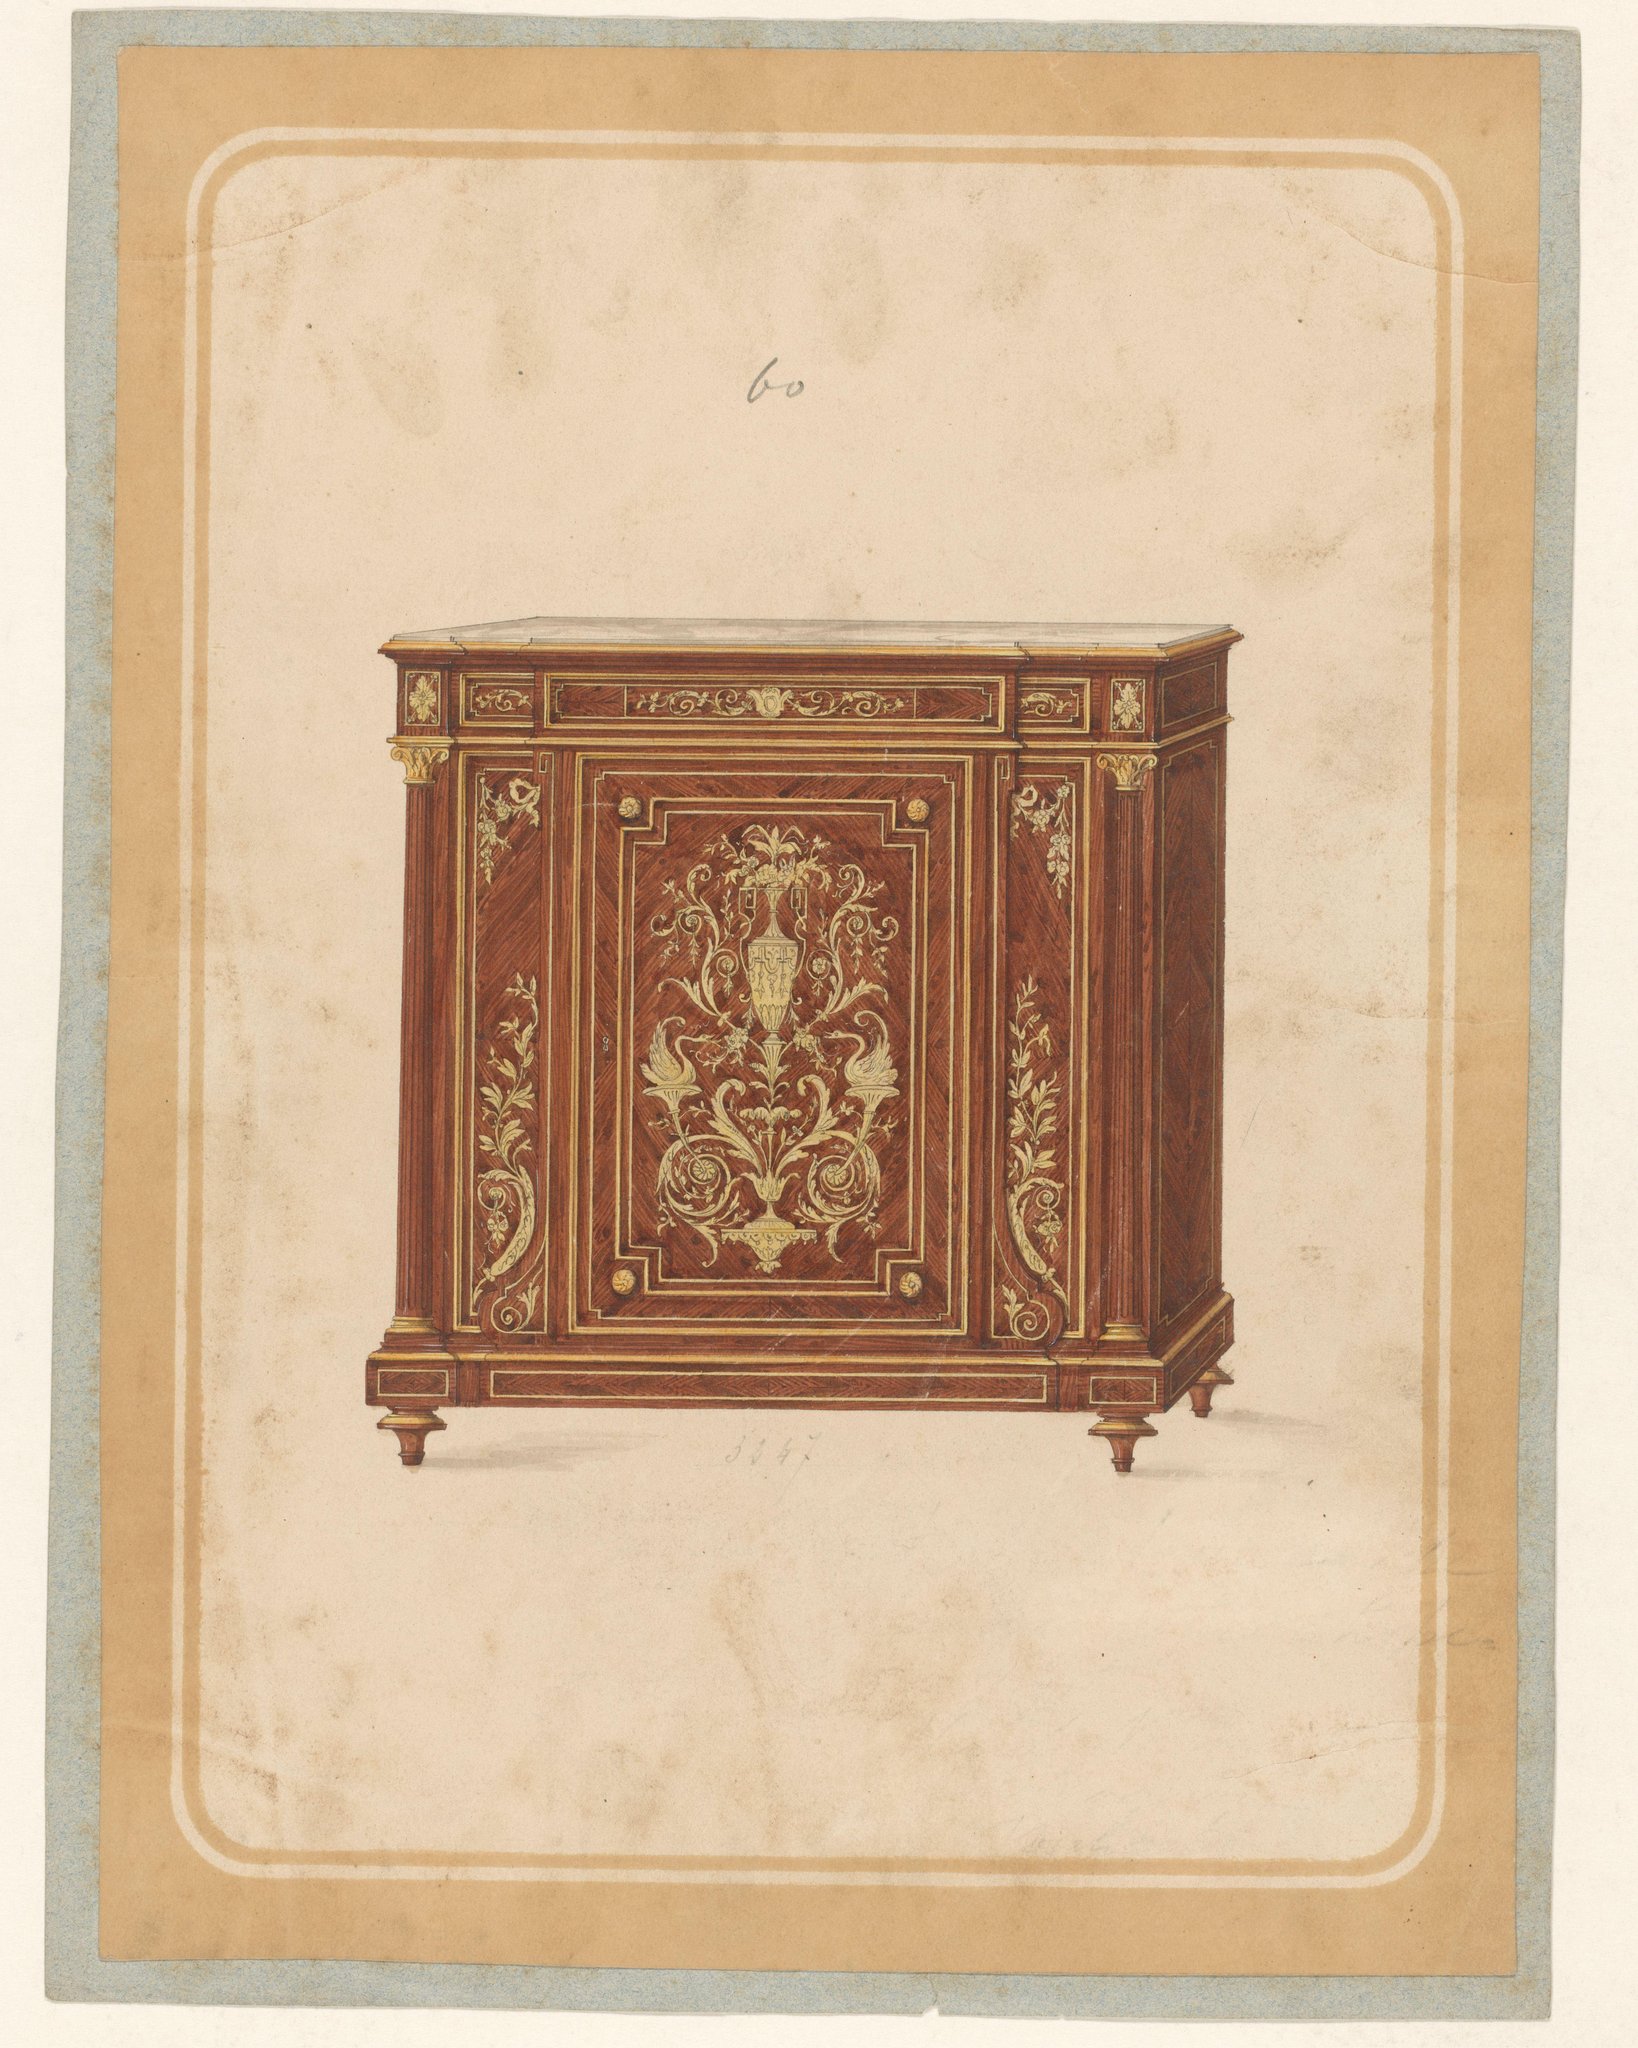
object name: print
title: Kast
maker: Anonymous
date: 1800-1900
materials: paper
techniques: hand coloring, lithograph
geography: france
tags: furniture for storage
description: Een lage geornamenteerde kast. In potlood genummerd 3347.